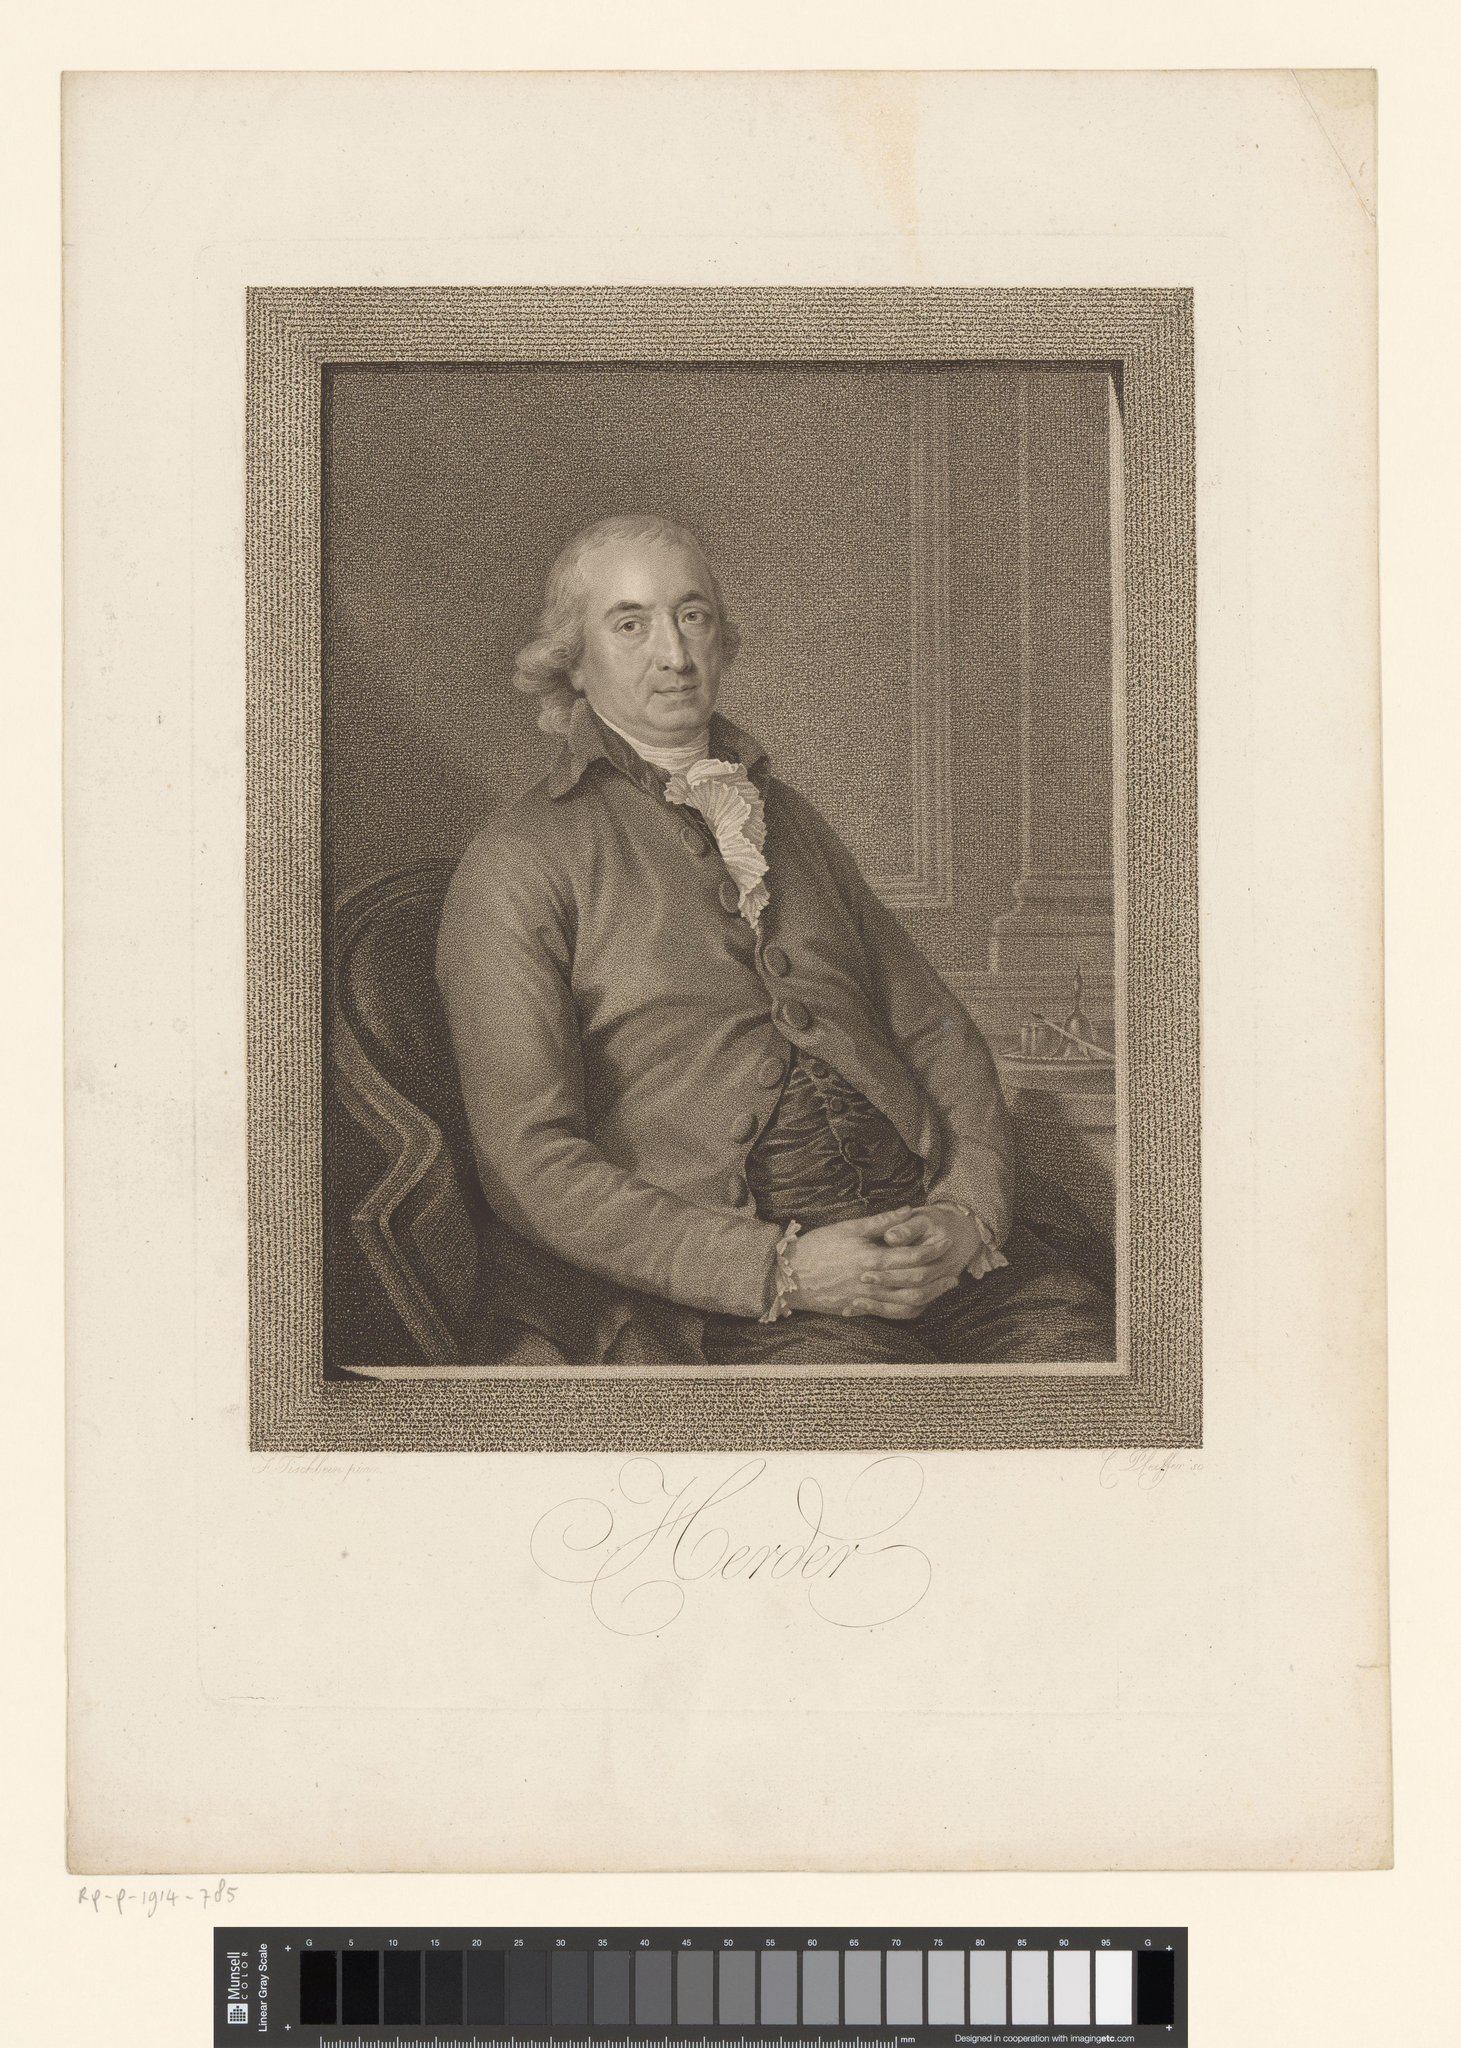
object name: print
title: Portret van Johann Gottfried von Herder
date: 1779-1829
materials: paper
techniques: stippled etching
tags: historical persons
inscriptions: collector's mark: Lugt 2228